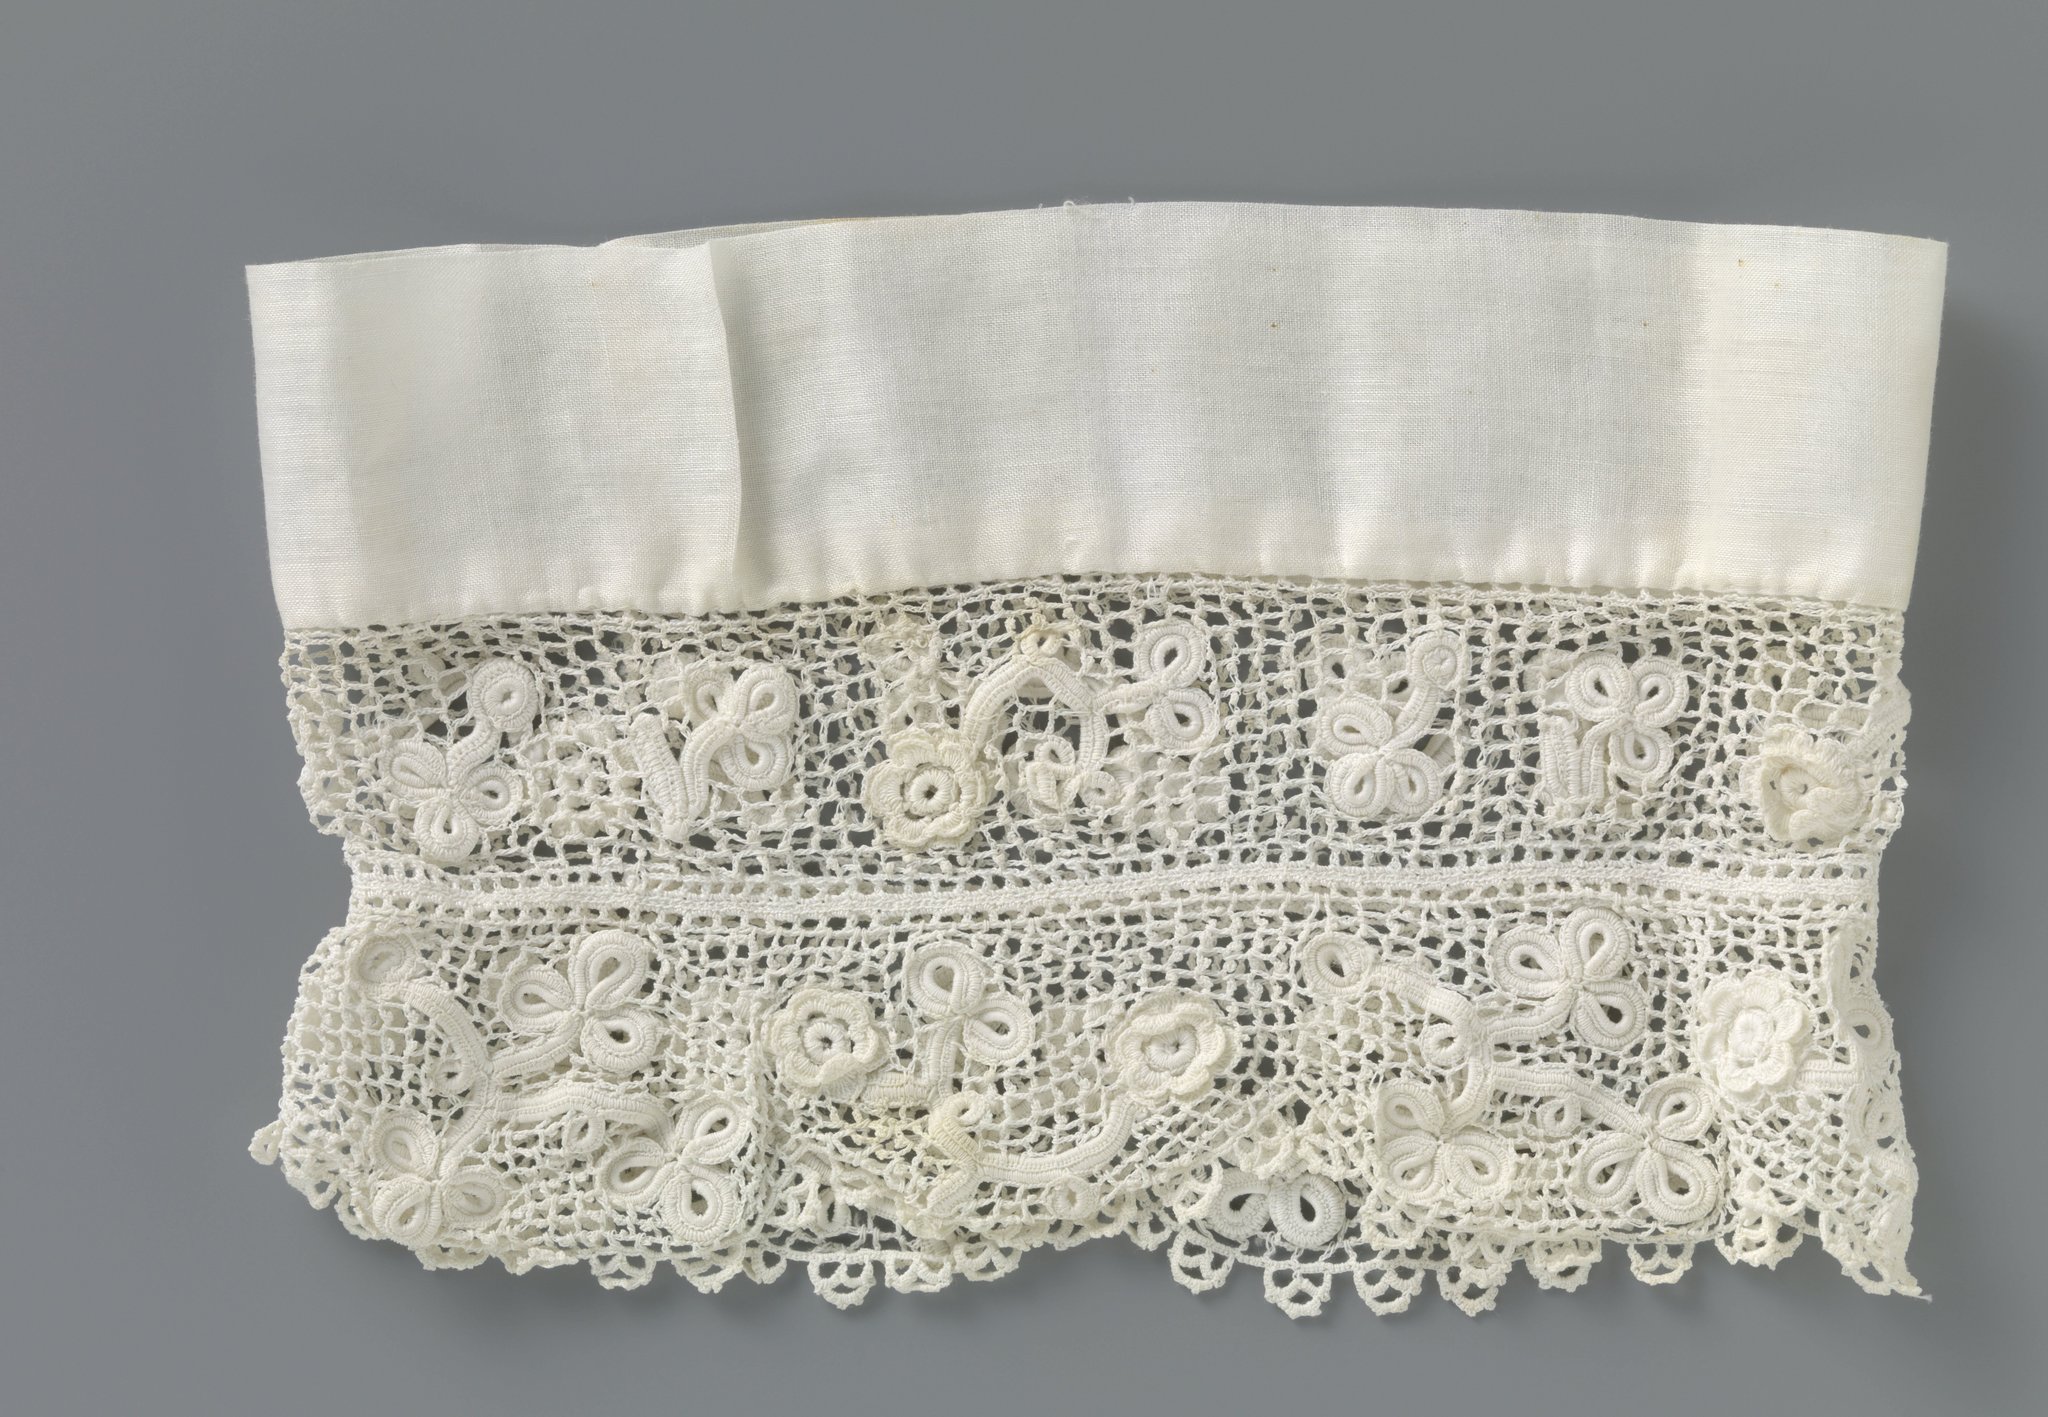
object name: cuff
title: Manchet van gehaakte kant met losse stengels en gelaagde rozetbloempjes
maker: Anonymous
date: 1890-1910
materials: cotton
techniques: crocheted lace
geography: ireland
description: Manchet gemaakt van twee stroken naturelkleurige Ierse gehaakte kant aan een strook witte katoen gezet. Het patroon van de strook die als tussenzetsels is gebruikt bestaat uit twee losse stengels waaraan een driedelig blad, afgewisseld door een losse stengel met een gelaagd rozetbloempje. Het patroon van de andere strook bestaat uit een losse stengel met driedelige bladeren afgewisseld door een losse stengel met aan weerszijden een gelaagd rozetbloempje. De regelmatige halfronde schulpen aan de onderzijde zijn afgezet met gepicoteerde boogjes. De grond met vierkante mazen in beide stroken doet denken aan het geknoopte netwerk van filetkant.